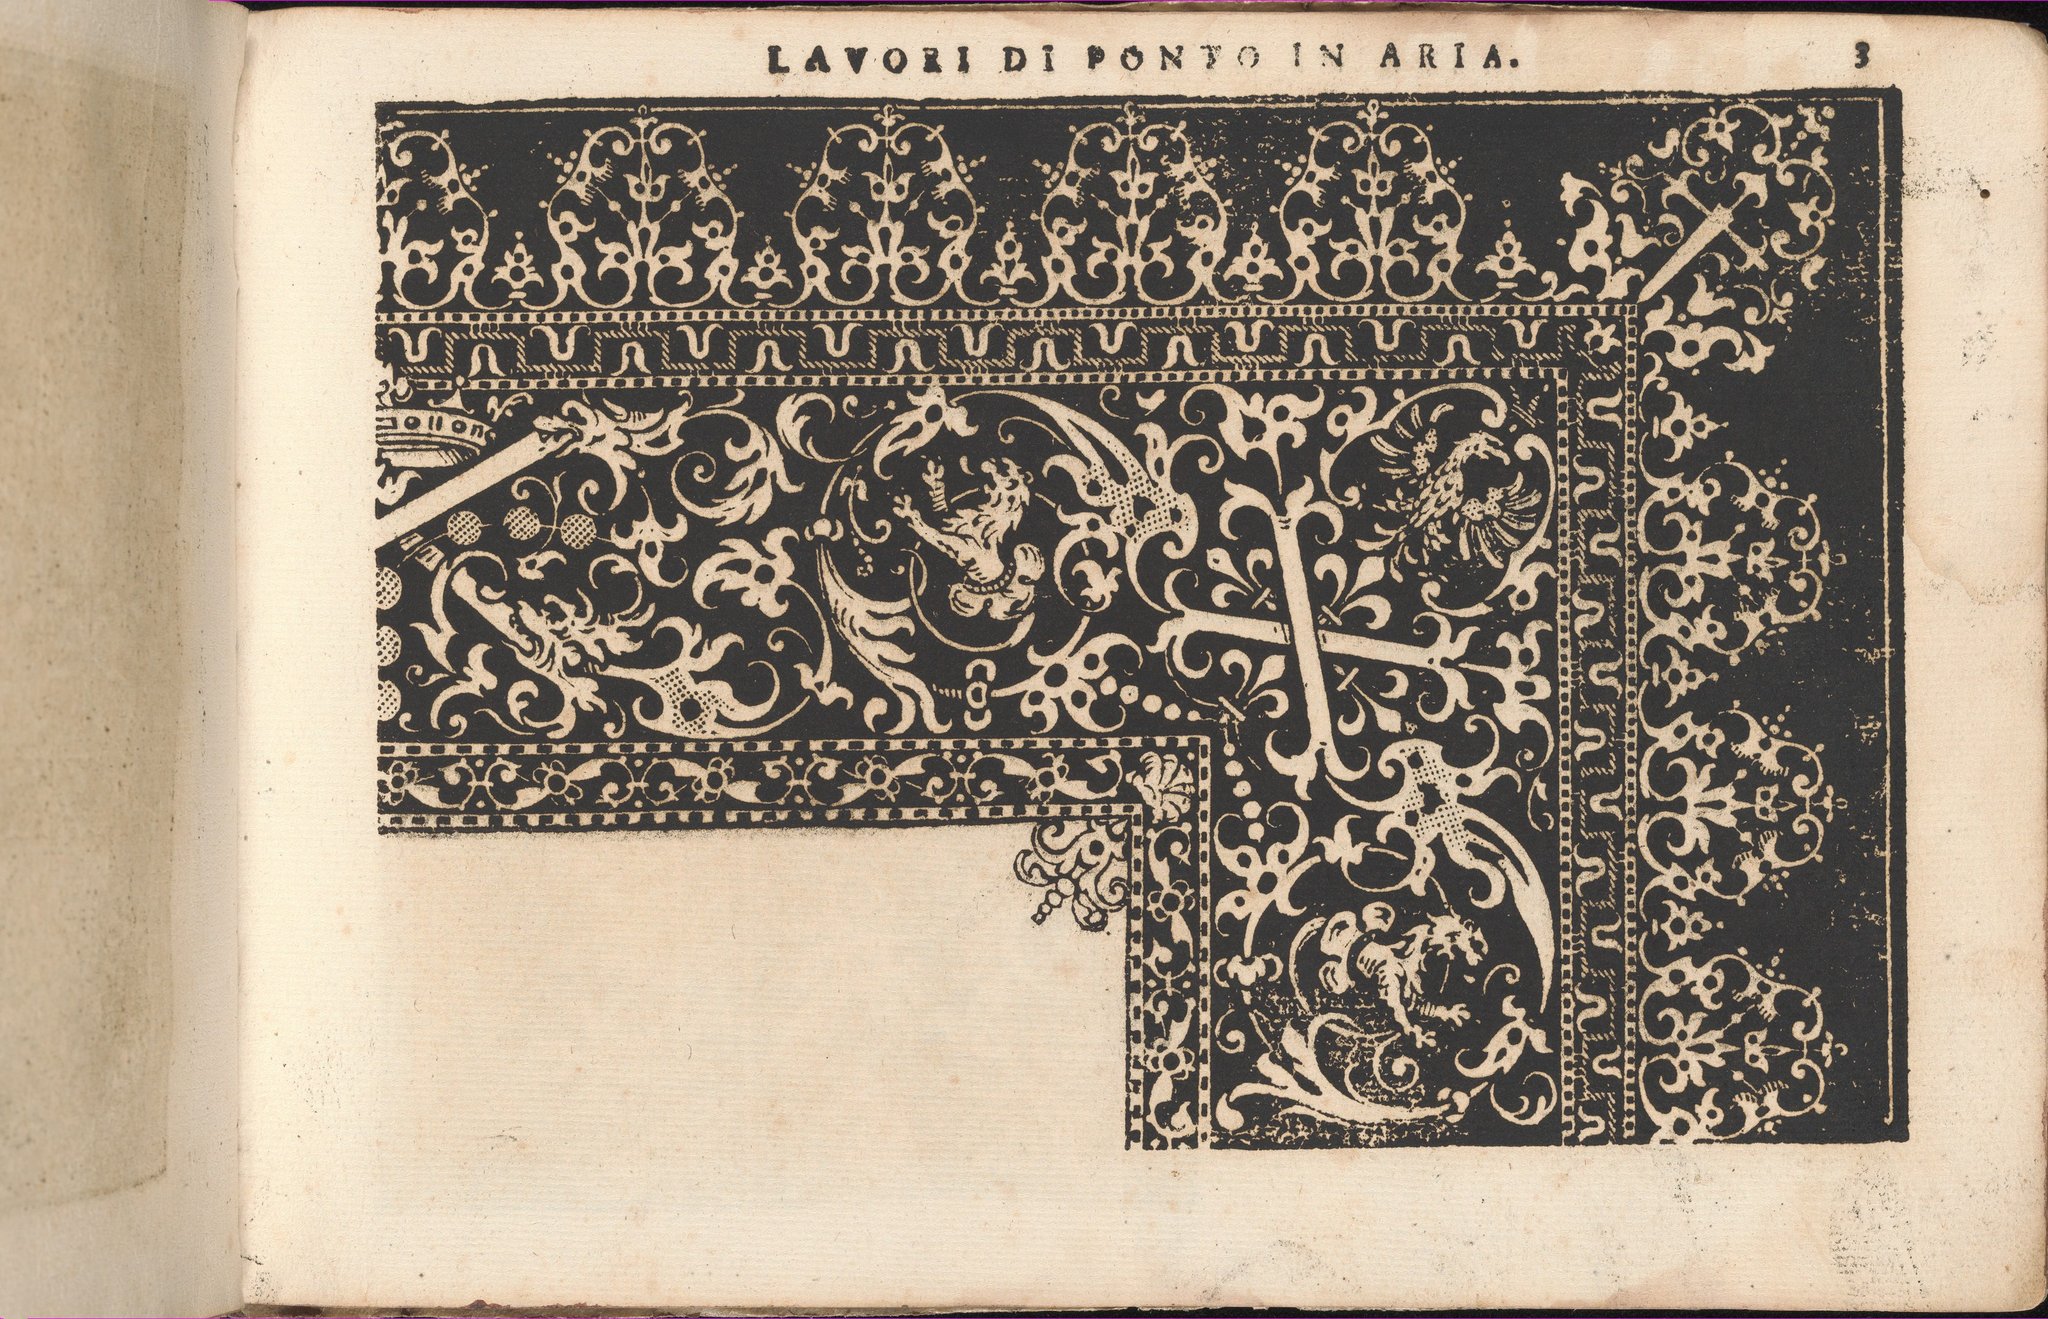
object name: book print ornament architecture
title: Teatro delle Nobili et Virtuose Donne..., page 11 (recto)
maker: isabella catanea parasole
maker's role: author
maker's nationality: italian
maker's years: 1565-1625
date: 1616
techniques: engraving, woodcut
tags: eagles,ornament